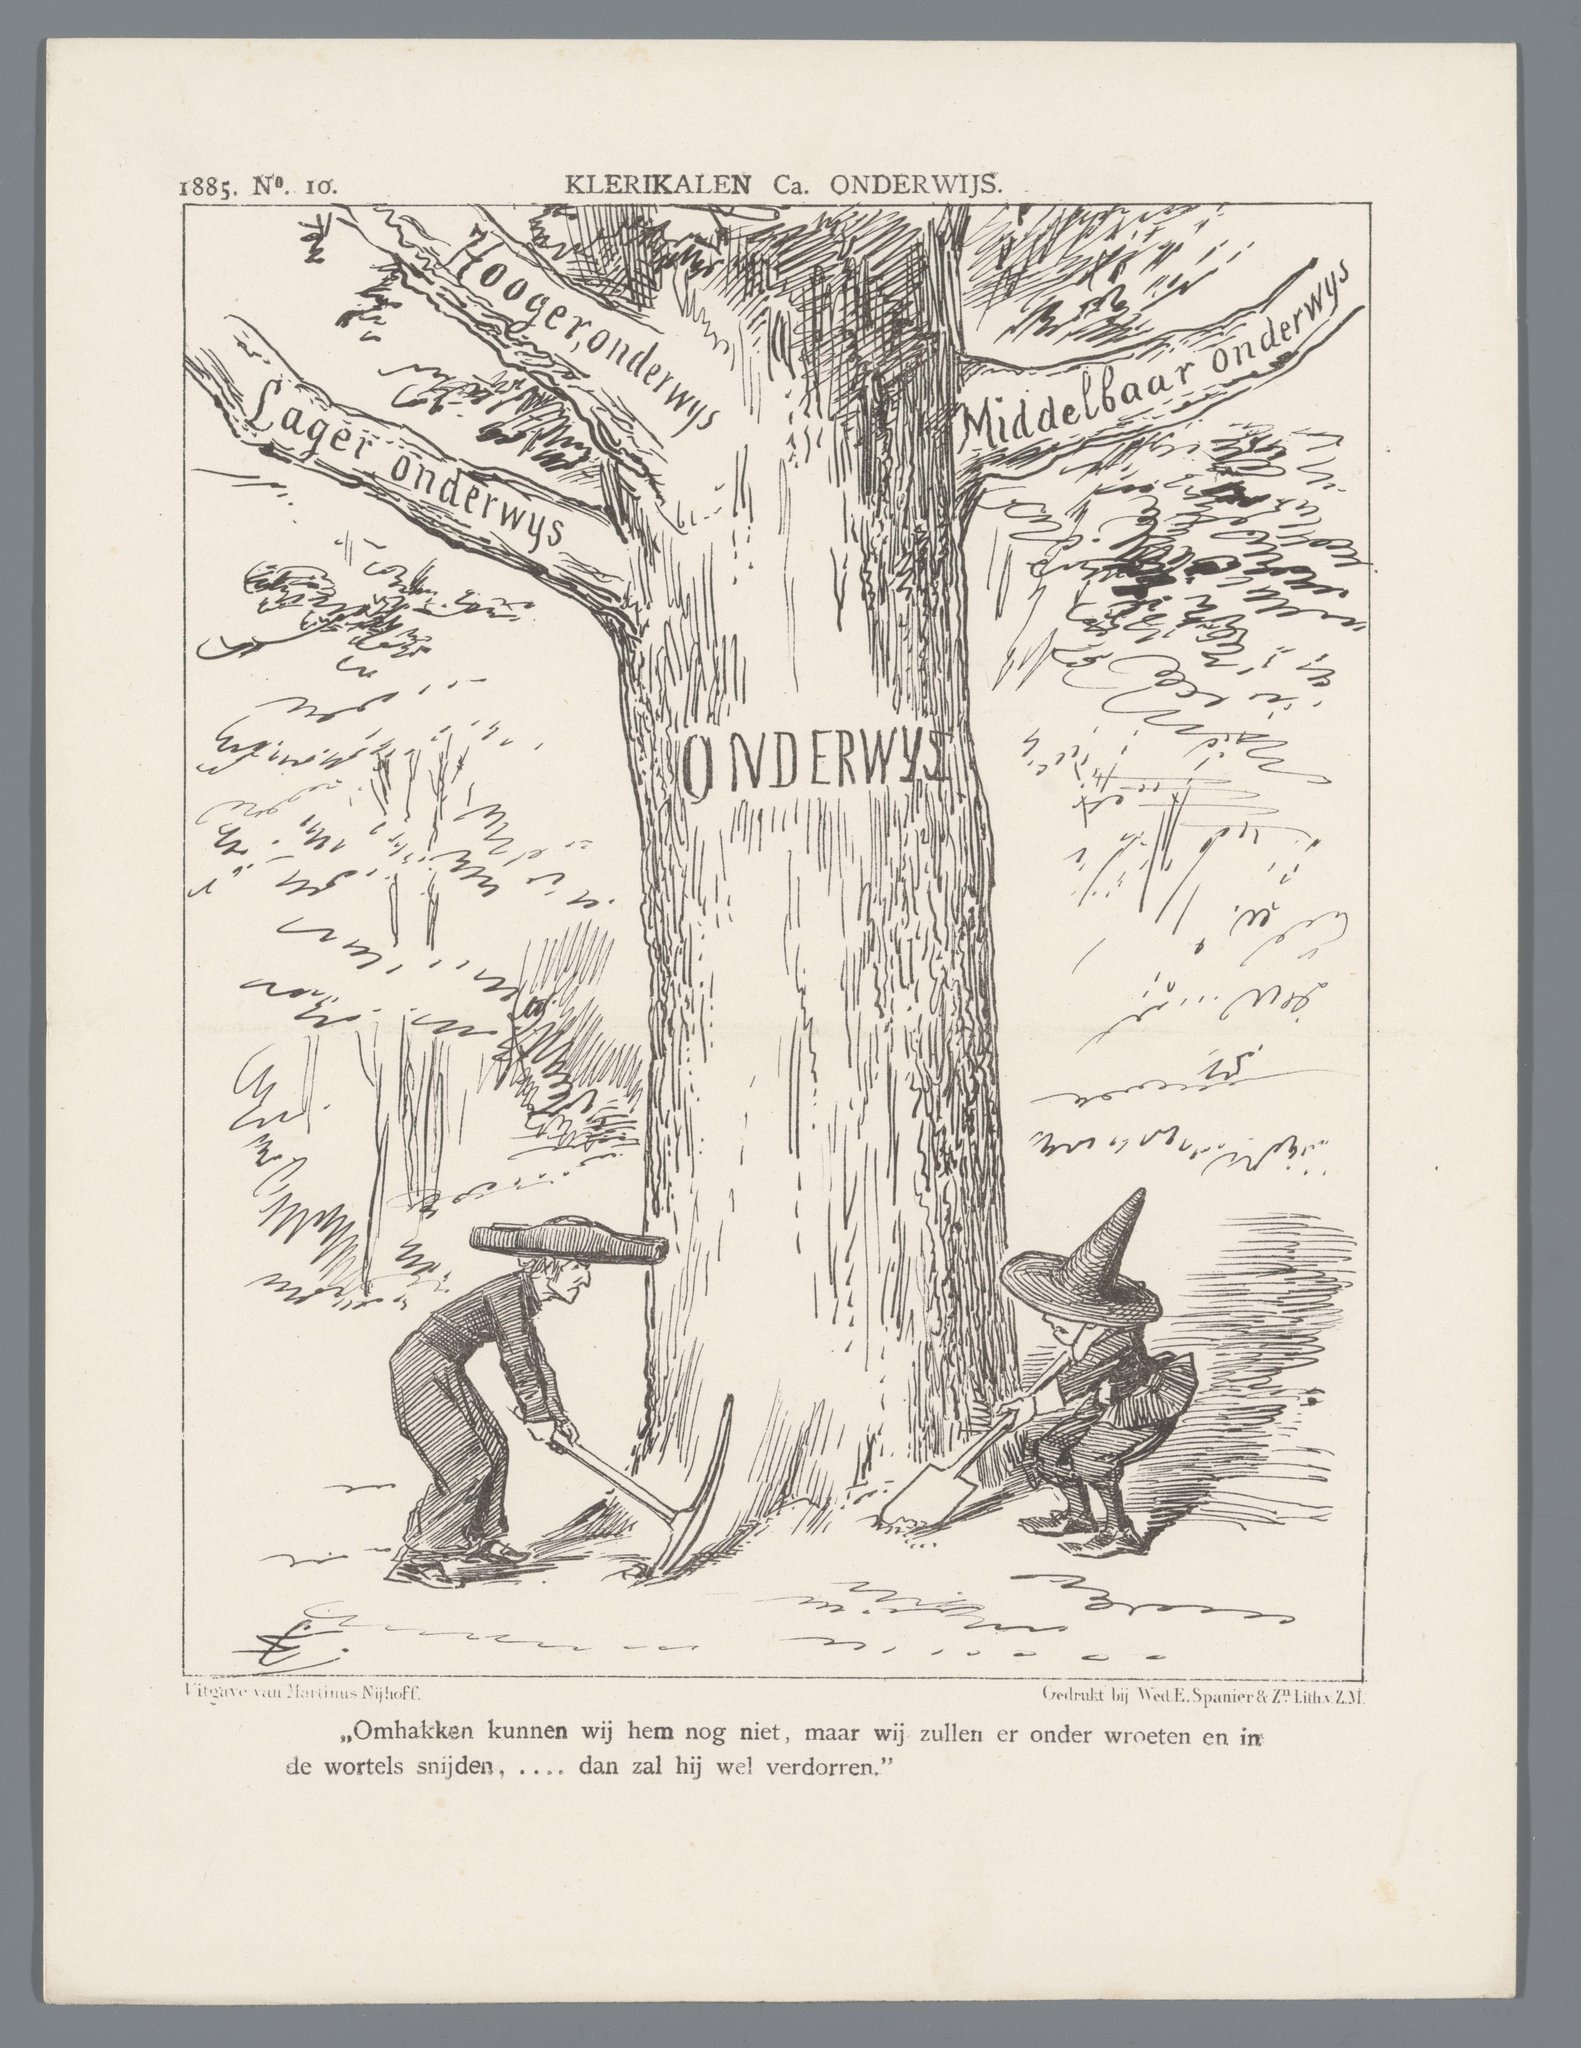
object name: cartoon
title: Spotprent op de klerikale partijen en het onderwijs, 1885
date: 1885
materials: paper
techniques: lithograph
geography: netherlands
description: Spotprent op de klerikale partijen en het onderwijs. Plaat verschenen bij het weekblad De Nederlandsche Spectator, nr. 10, 1885.